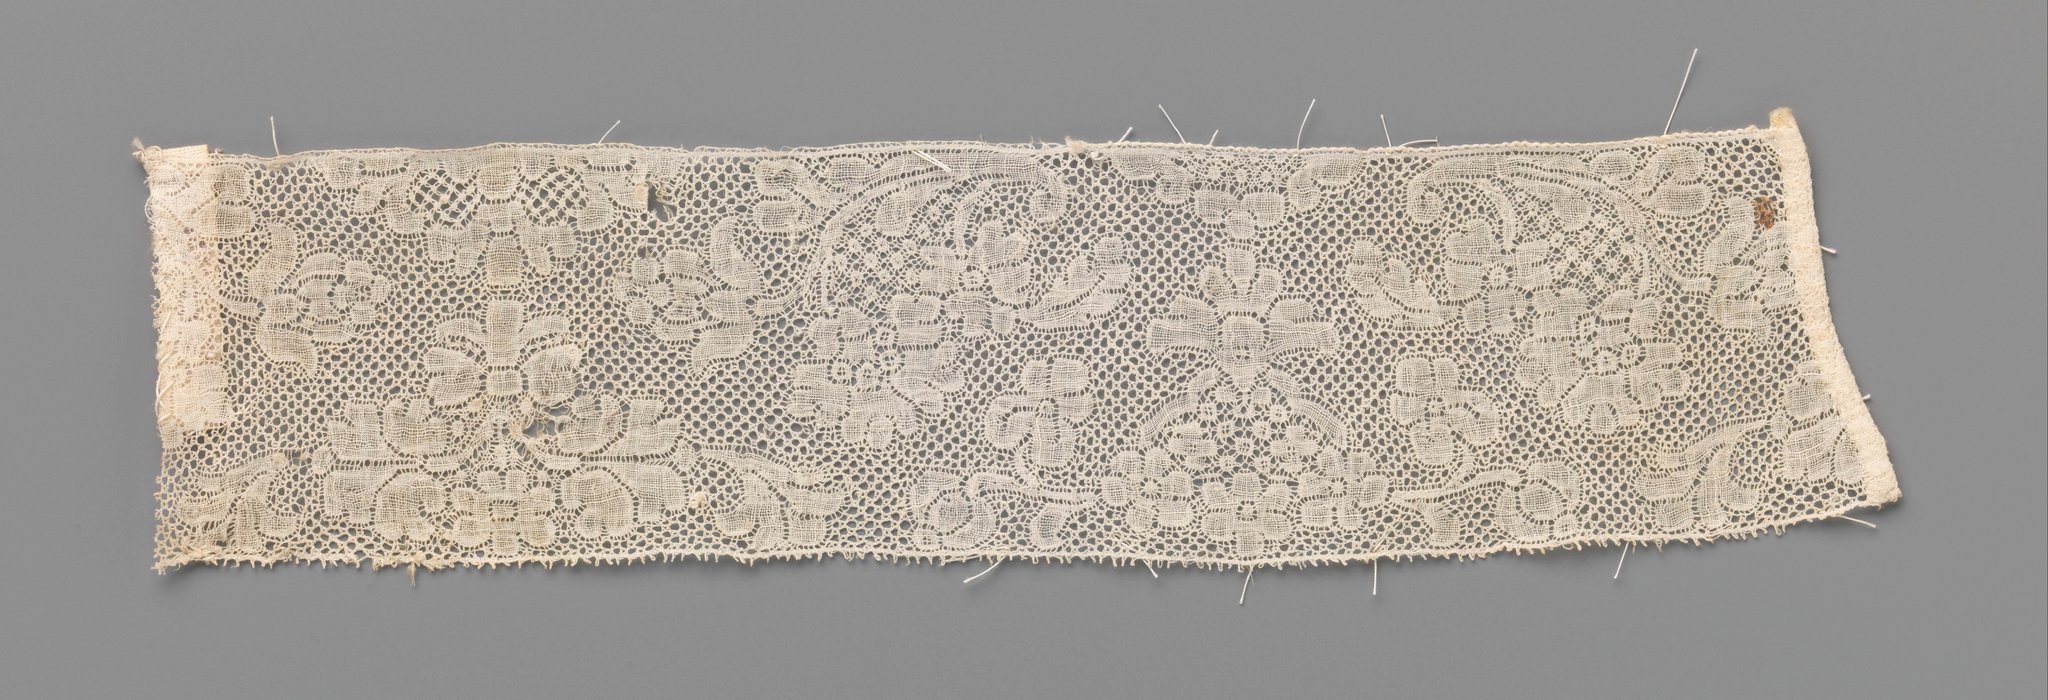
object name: strip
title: Strook kloskant met cartouche met drie rozetbloempjes langs de onderzijde en een waaiervormige bloem in de top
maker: Anonymous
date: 1700-1899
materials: linen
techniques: lace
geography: flanders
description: Strook naturelkleurige kloskant, Binche-kant. Het patroon bestaat uit twee symmetrische composities, elk bekroond door een grote gehalveerde bloem langs de bovenzijde, geflankeerd door een gebogen tak met drie verschillende bloemen eraan. Bij de ene compositie staan daaronder twee gestapelde bloemen tussen twee bladeren met een kort gevederd blad aan het uiteinde. Bij de andere compositie betreft het een cartouche met drie rozetbloempjes langs de onderzijde en een waaiervormige bloem in de top. De motieven zijn met elkaar verbonden door een traliegrond, een vijfgaatjesgrond. De motieven zijn gemaakt in linnenslag met uitsparingen en opengewerkte randjes. In de cartouches, tussen de bloemstengels en in de bloemen zijn siergronden toegepast, met name sneeuwvlokkengronden. De boven- en onderzijde van de strook zijn recht afgewerkt, waarbij de onderzijde is voorzien van picots. Eén van de korte zijden is afgewerkt met een linnen bandje, waarmee een zoompje is gemaakt.